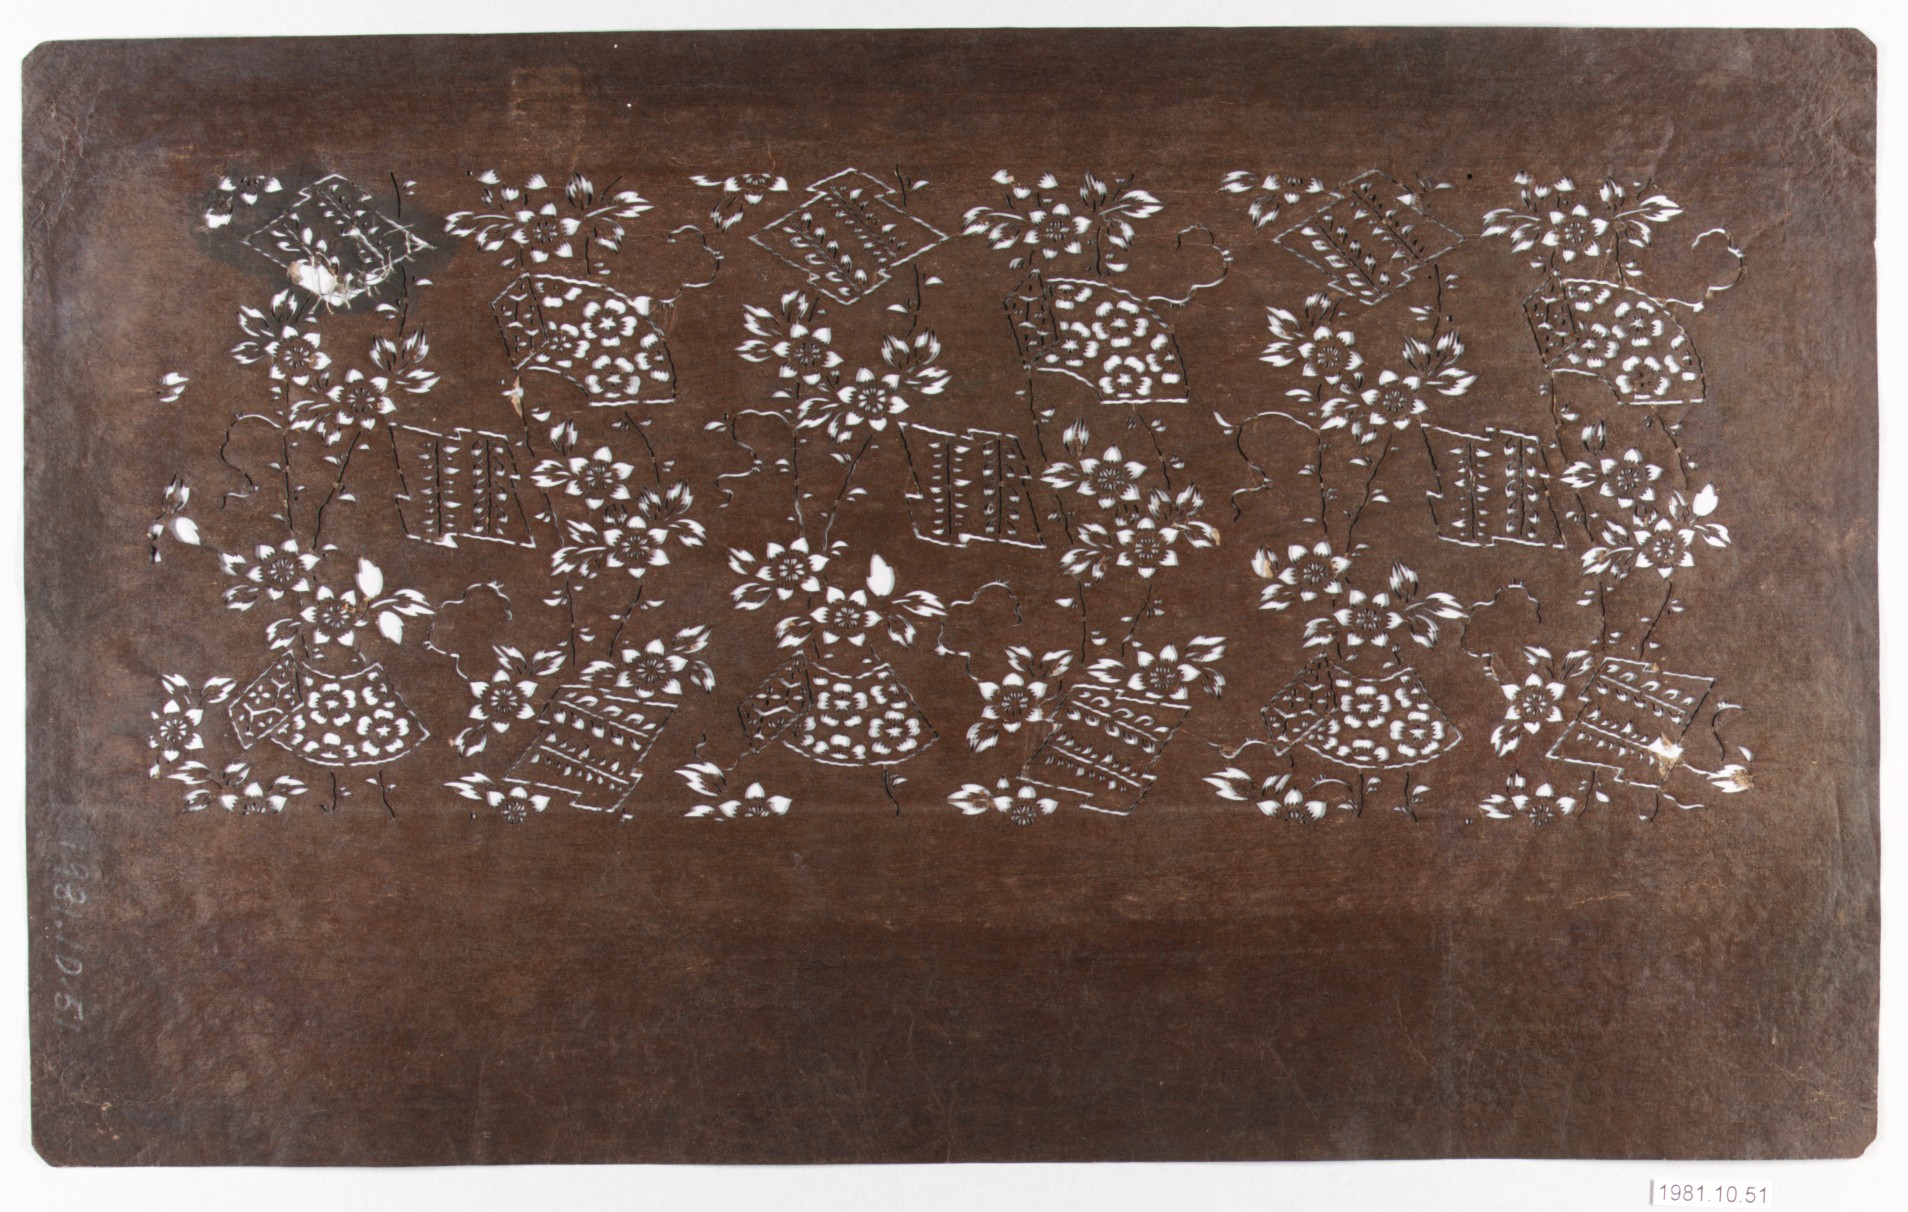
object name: stencil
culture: japanese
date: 1801-1900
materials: paper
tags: flowers